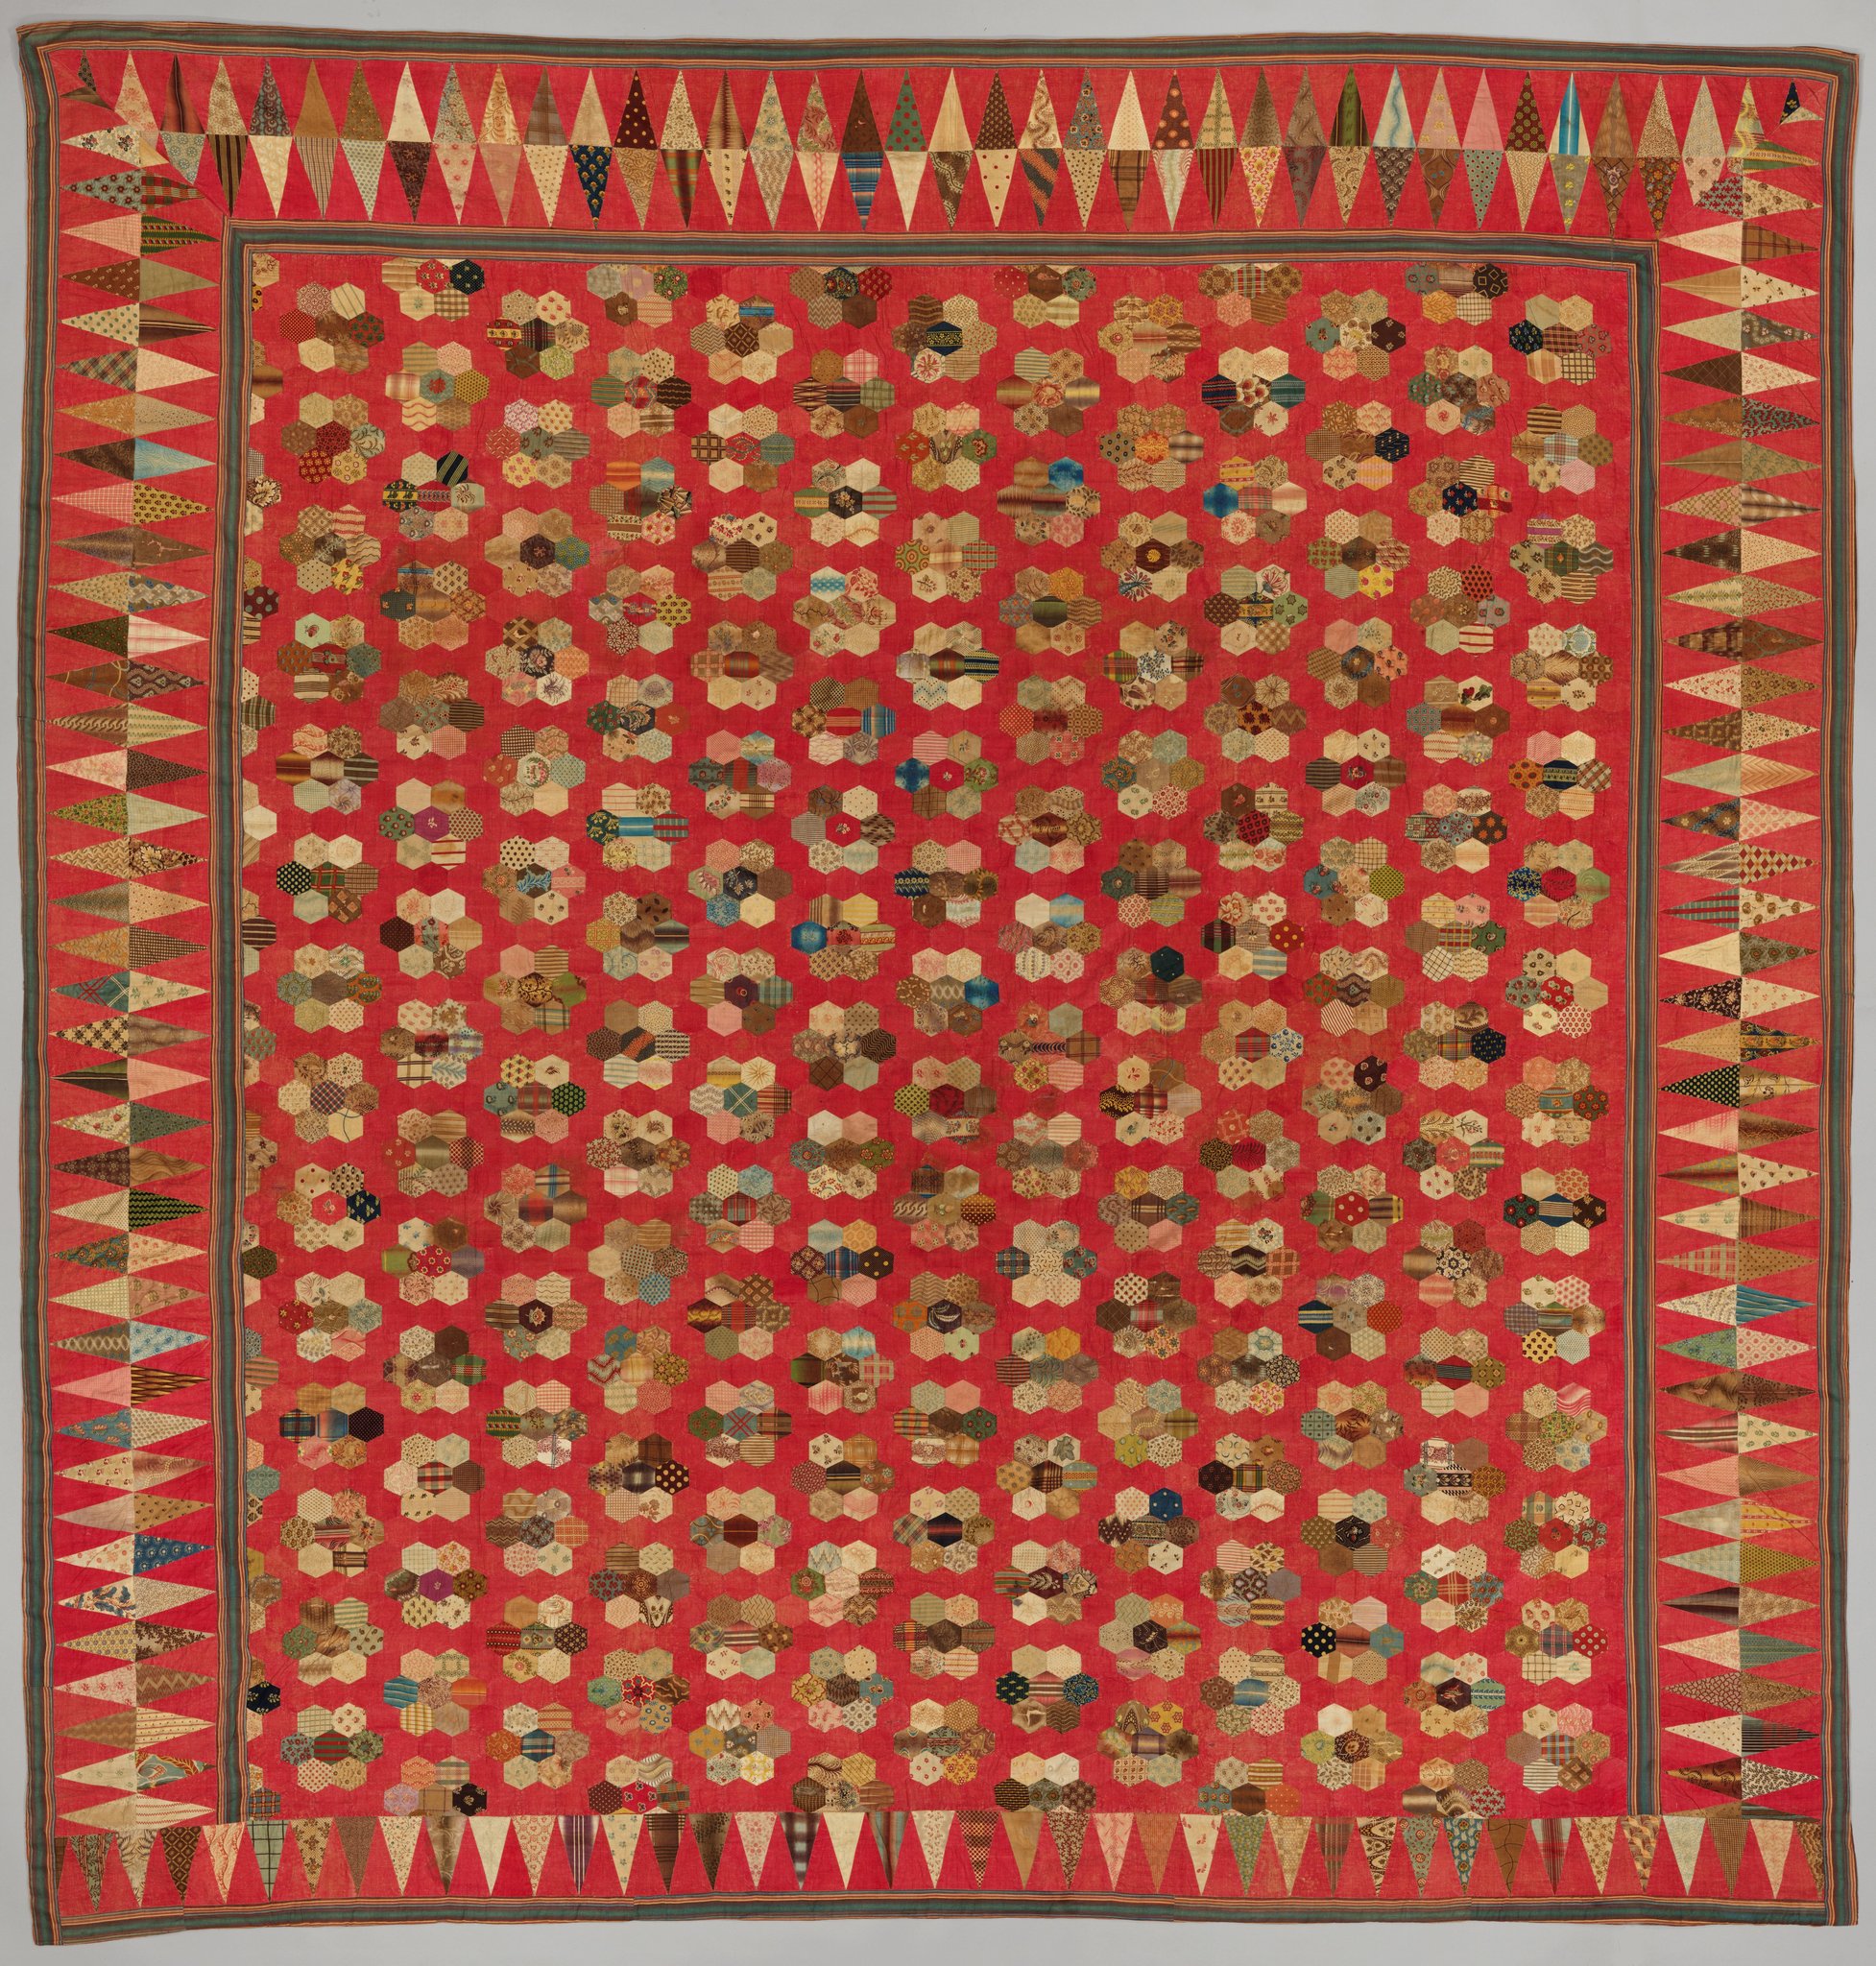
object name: bed covering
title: Bedsprei in patchwork van gedrukte katoentjes met motief van rozen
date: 1800-1850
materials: cotton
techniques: printing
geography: netherlands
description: Bedsprei in patchwork van gedrukte katoentjes. In het midden in banen geplaatste rozen die horizontaal verspringende rijen vormen, staan tegen een rode fond, ook van zeshoekjes. De roosjes bestaan elk uit zeven zeshoekjes, willekeurig van kleur gecombineerd. De rand is als een tric-trac bord met gerekte driehoeken van bont katoen, ruggelings tegen elkaar genaaid, die afsteken tegen effen driehoekjes in rood. Groen gestreepte binnen- en buitenlijsten.